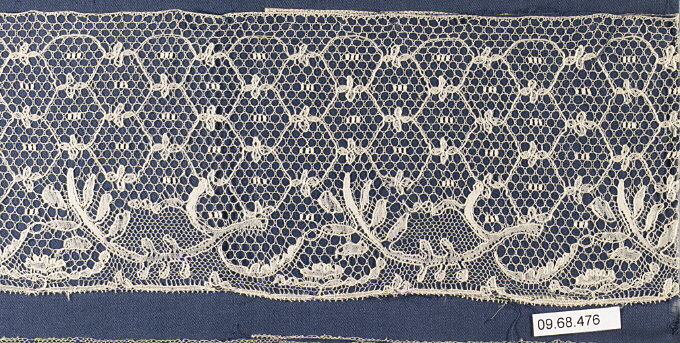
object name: fragment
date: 1801-1900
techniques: lace